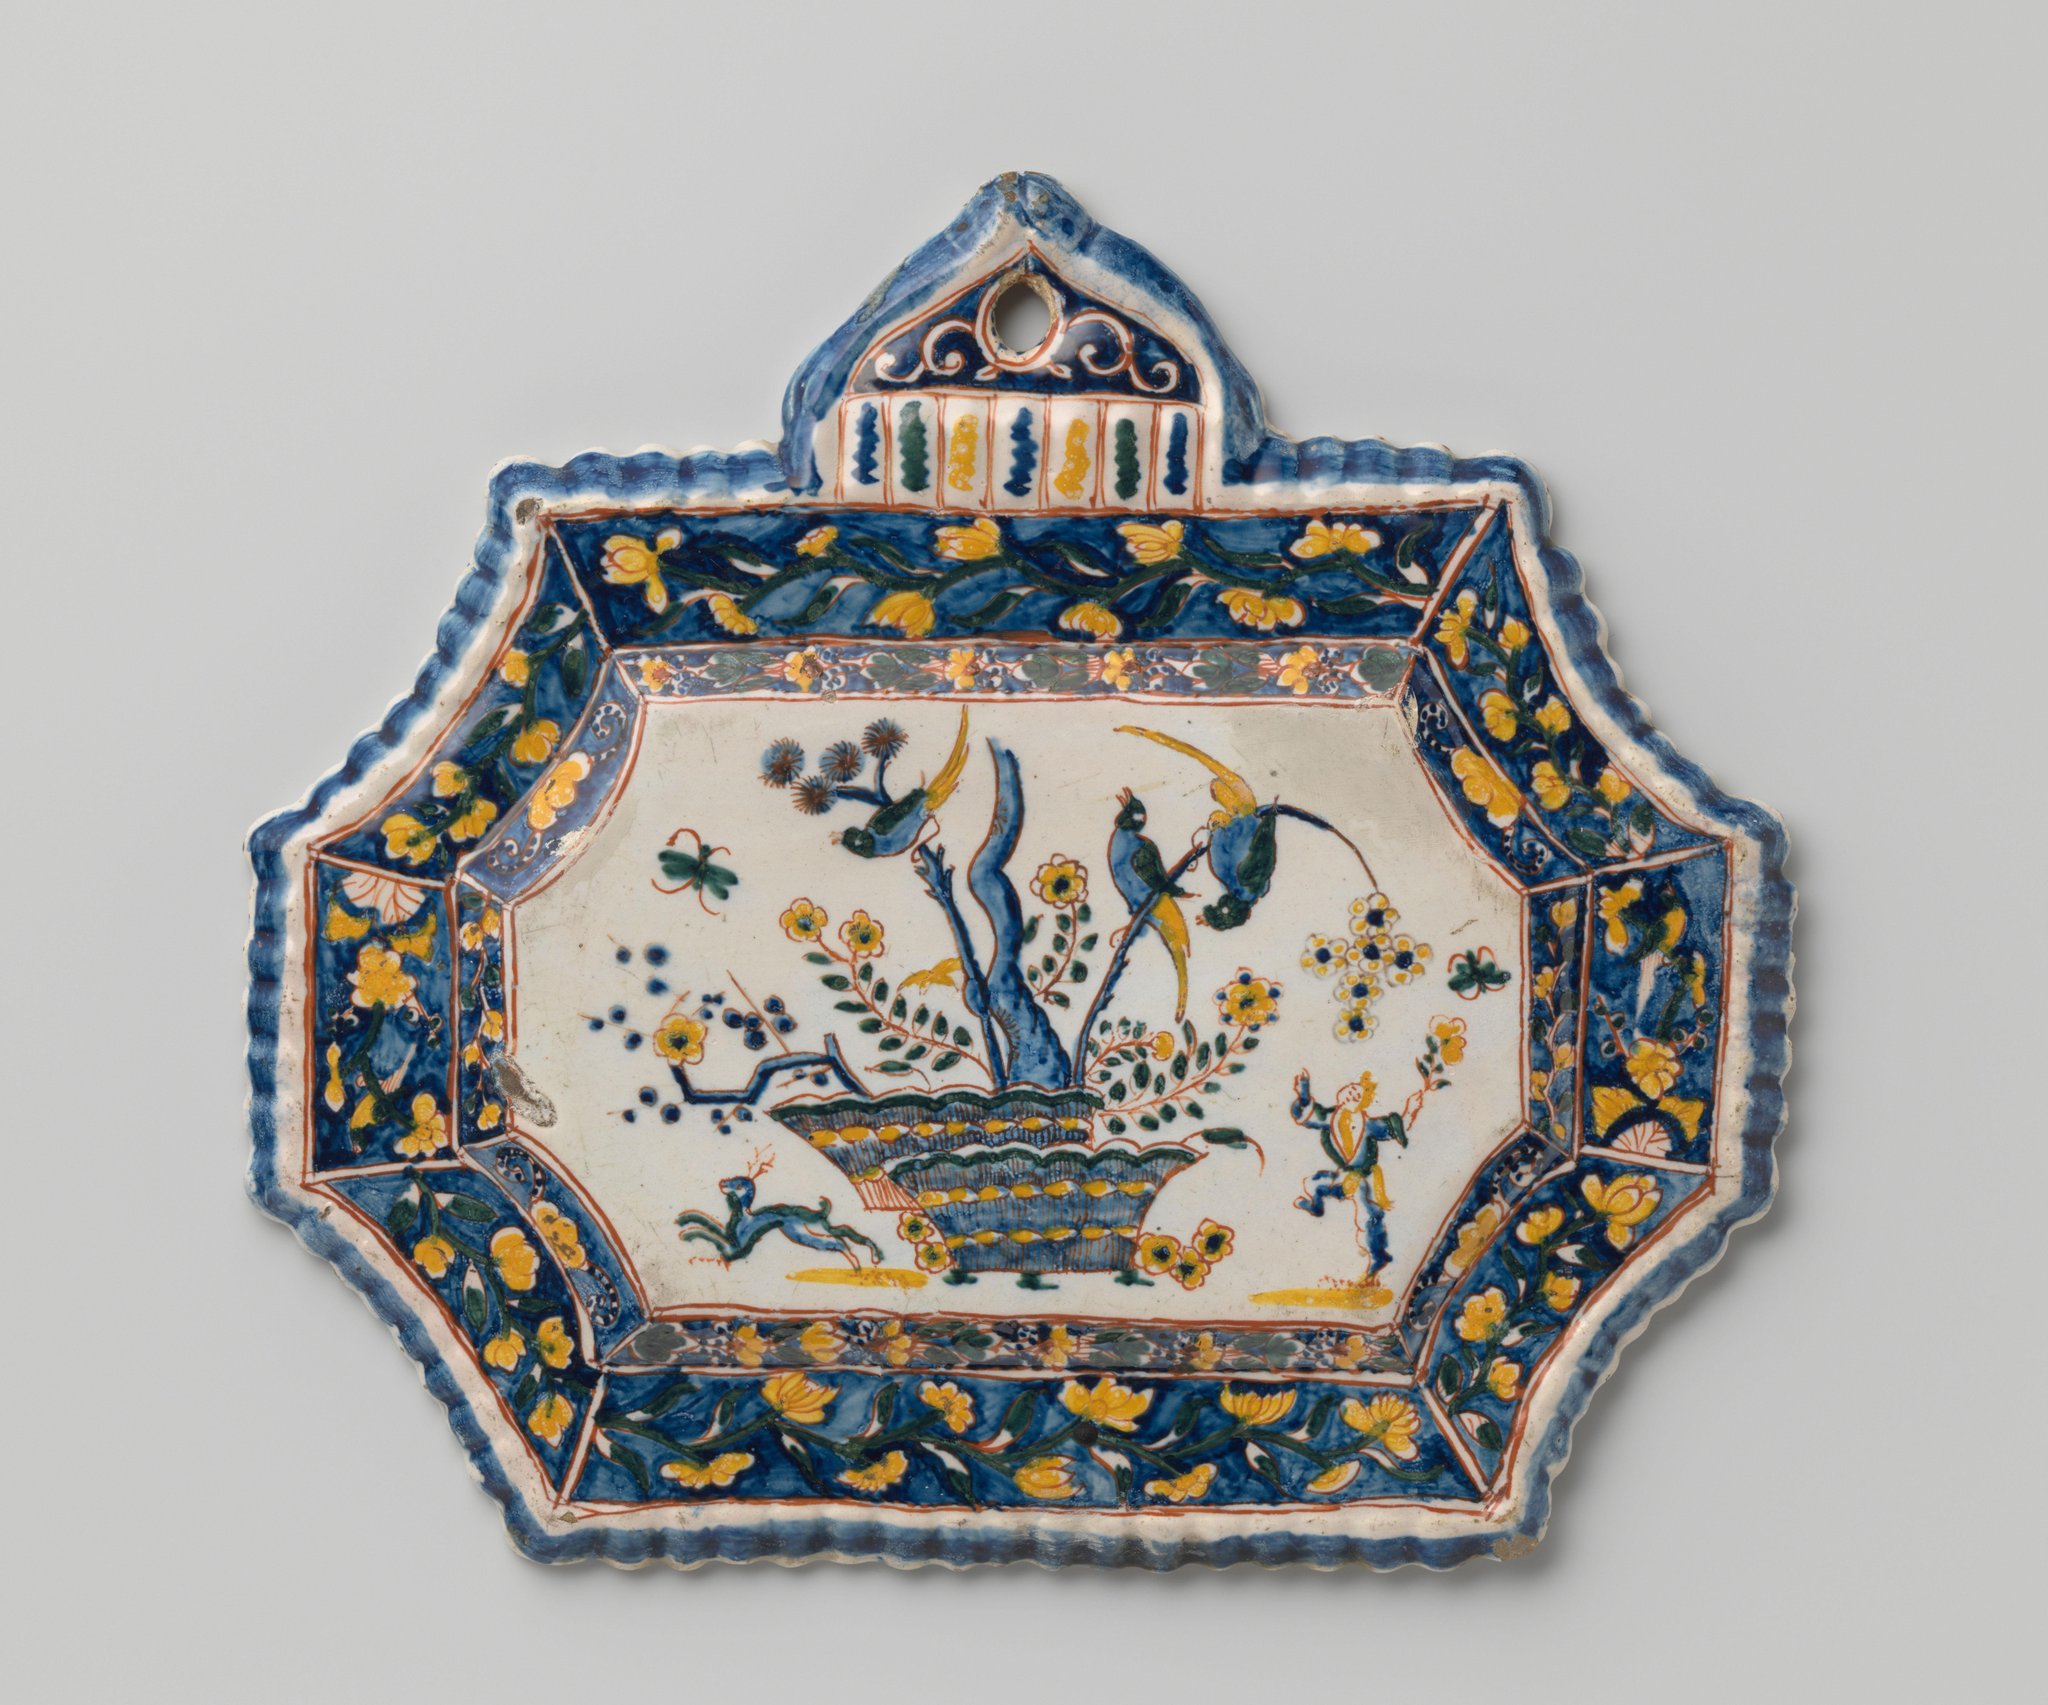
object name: plate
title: Plaat, rechthoekig met uitgeschulpte hoeken, veelkleurig beschilderd met een Chinees plantornament met vogels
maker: Anonymous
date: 1755-1780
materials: earthenware, glaze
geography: delft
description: Plaat, rechthoekig met uitgeschulpte hoeken, veelkleurig beschilderd met Chinees plantornament met vogels.